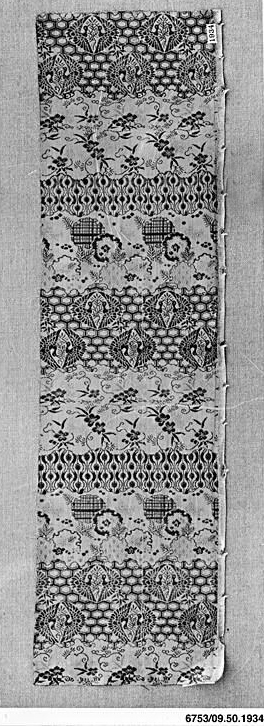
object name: piece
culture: japanese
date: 1801-1900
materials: metal thread, silk